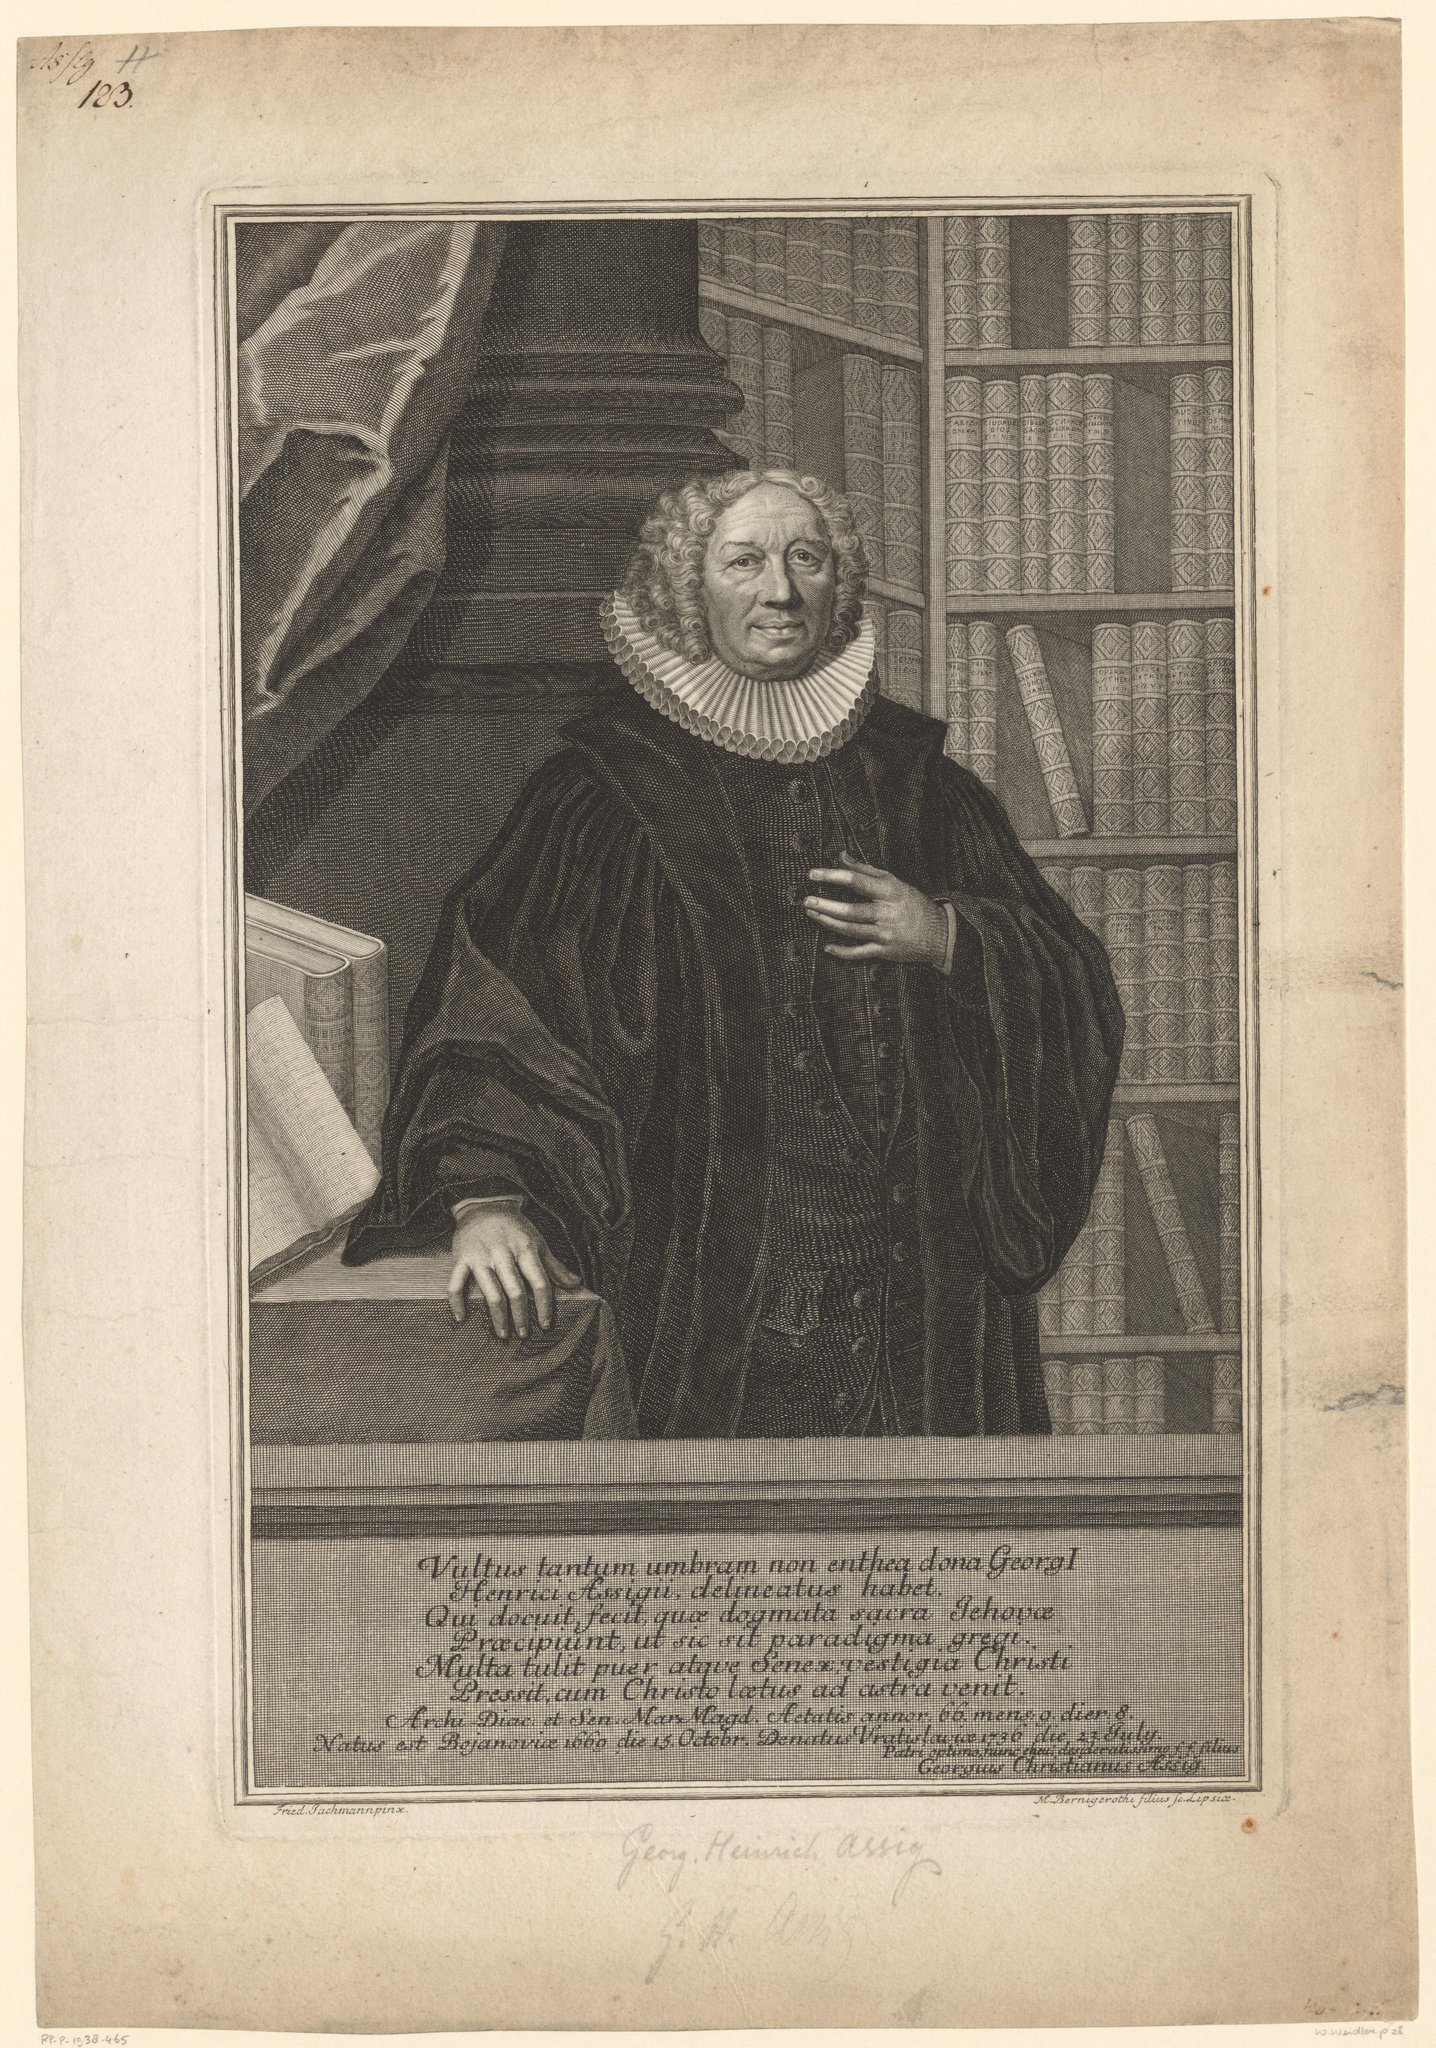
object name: print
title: Portret van Georg Heinrich von Assig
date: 1736-1767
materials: paper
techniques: engraving, etching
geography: leipzig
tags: bookshelves, historical persons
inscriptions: collector's mark: Lugt 2228